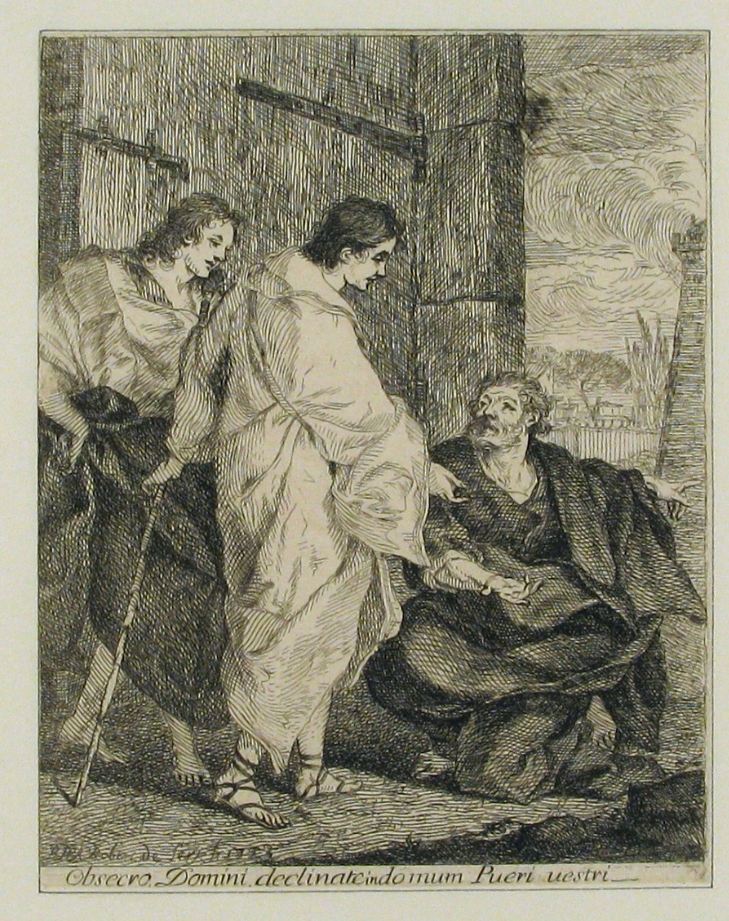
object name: print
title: Lot Invites Two Angels to Enter His Home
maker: paul ponce antoine robert-de-seri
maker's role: artist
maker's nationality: french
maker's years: 1686-1733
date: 1723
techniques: etching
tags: men,angels